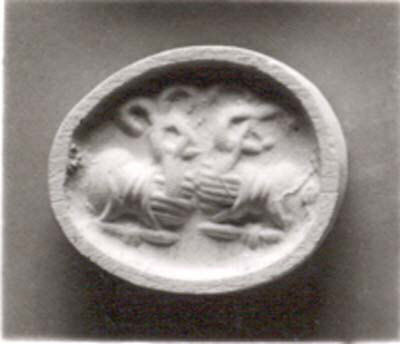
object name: stamp seal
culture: sasanian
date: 201-700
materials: mineral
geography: iran or mesopotamia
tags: rams